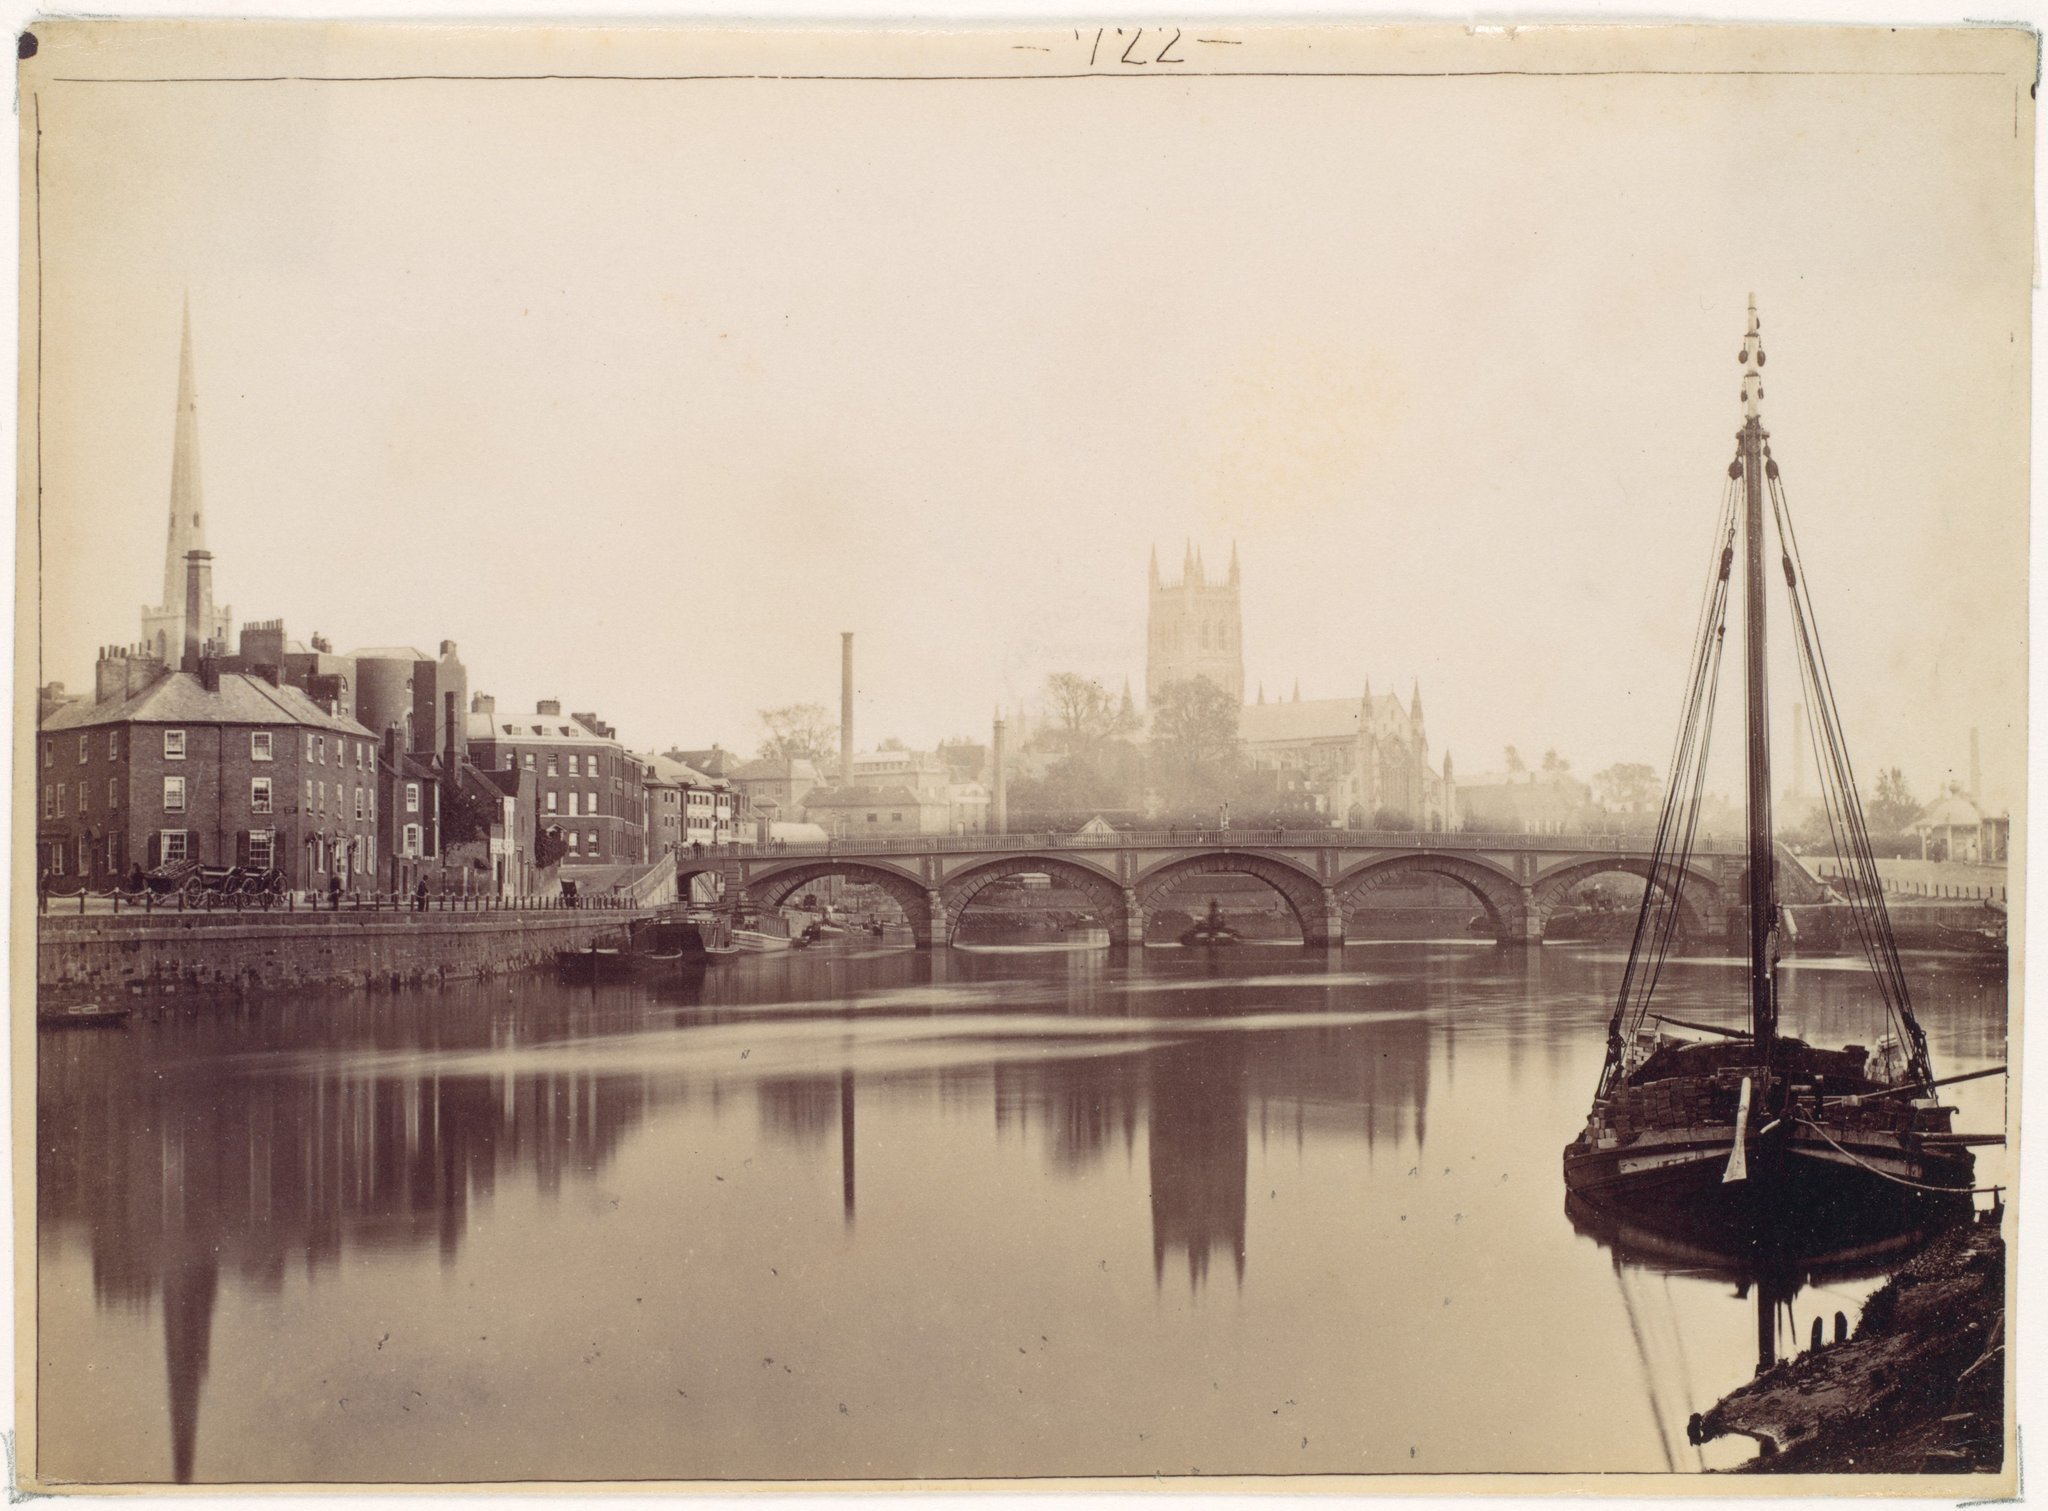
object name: photograph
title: Worcester. From the Severn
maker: francis bedford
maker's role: artist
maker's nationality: british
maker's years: 1816-1894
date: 1870-1879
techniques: albumen silver print, glass negative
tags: buildings,cities,bridges,boats